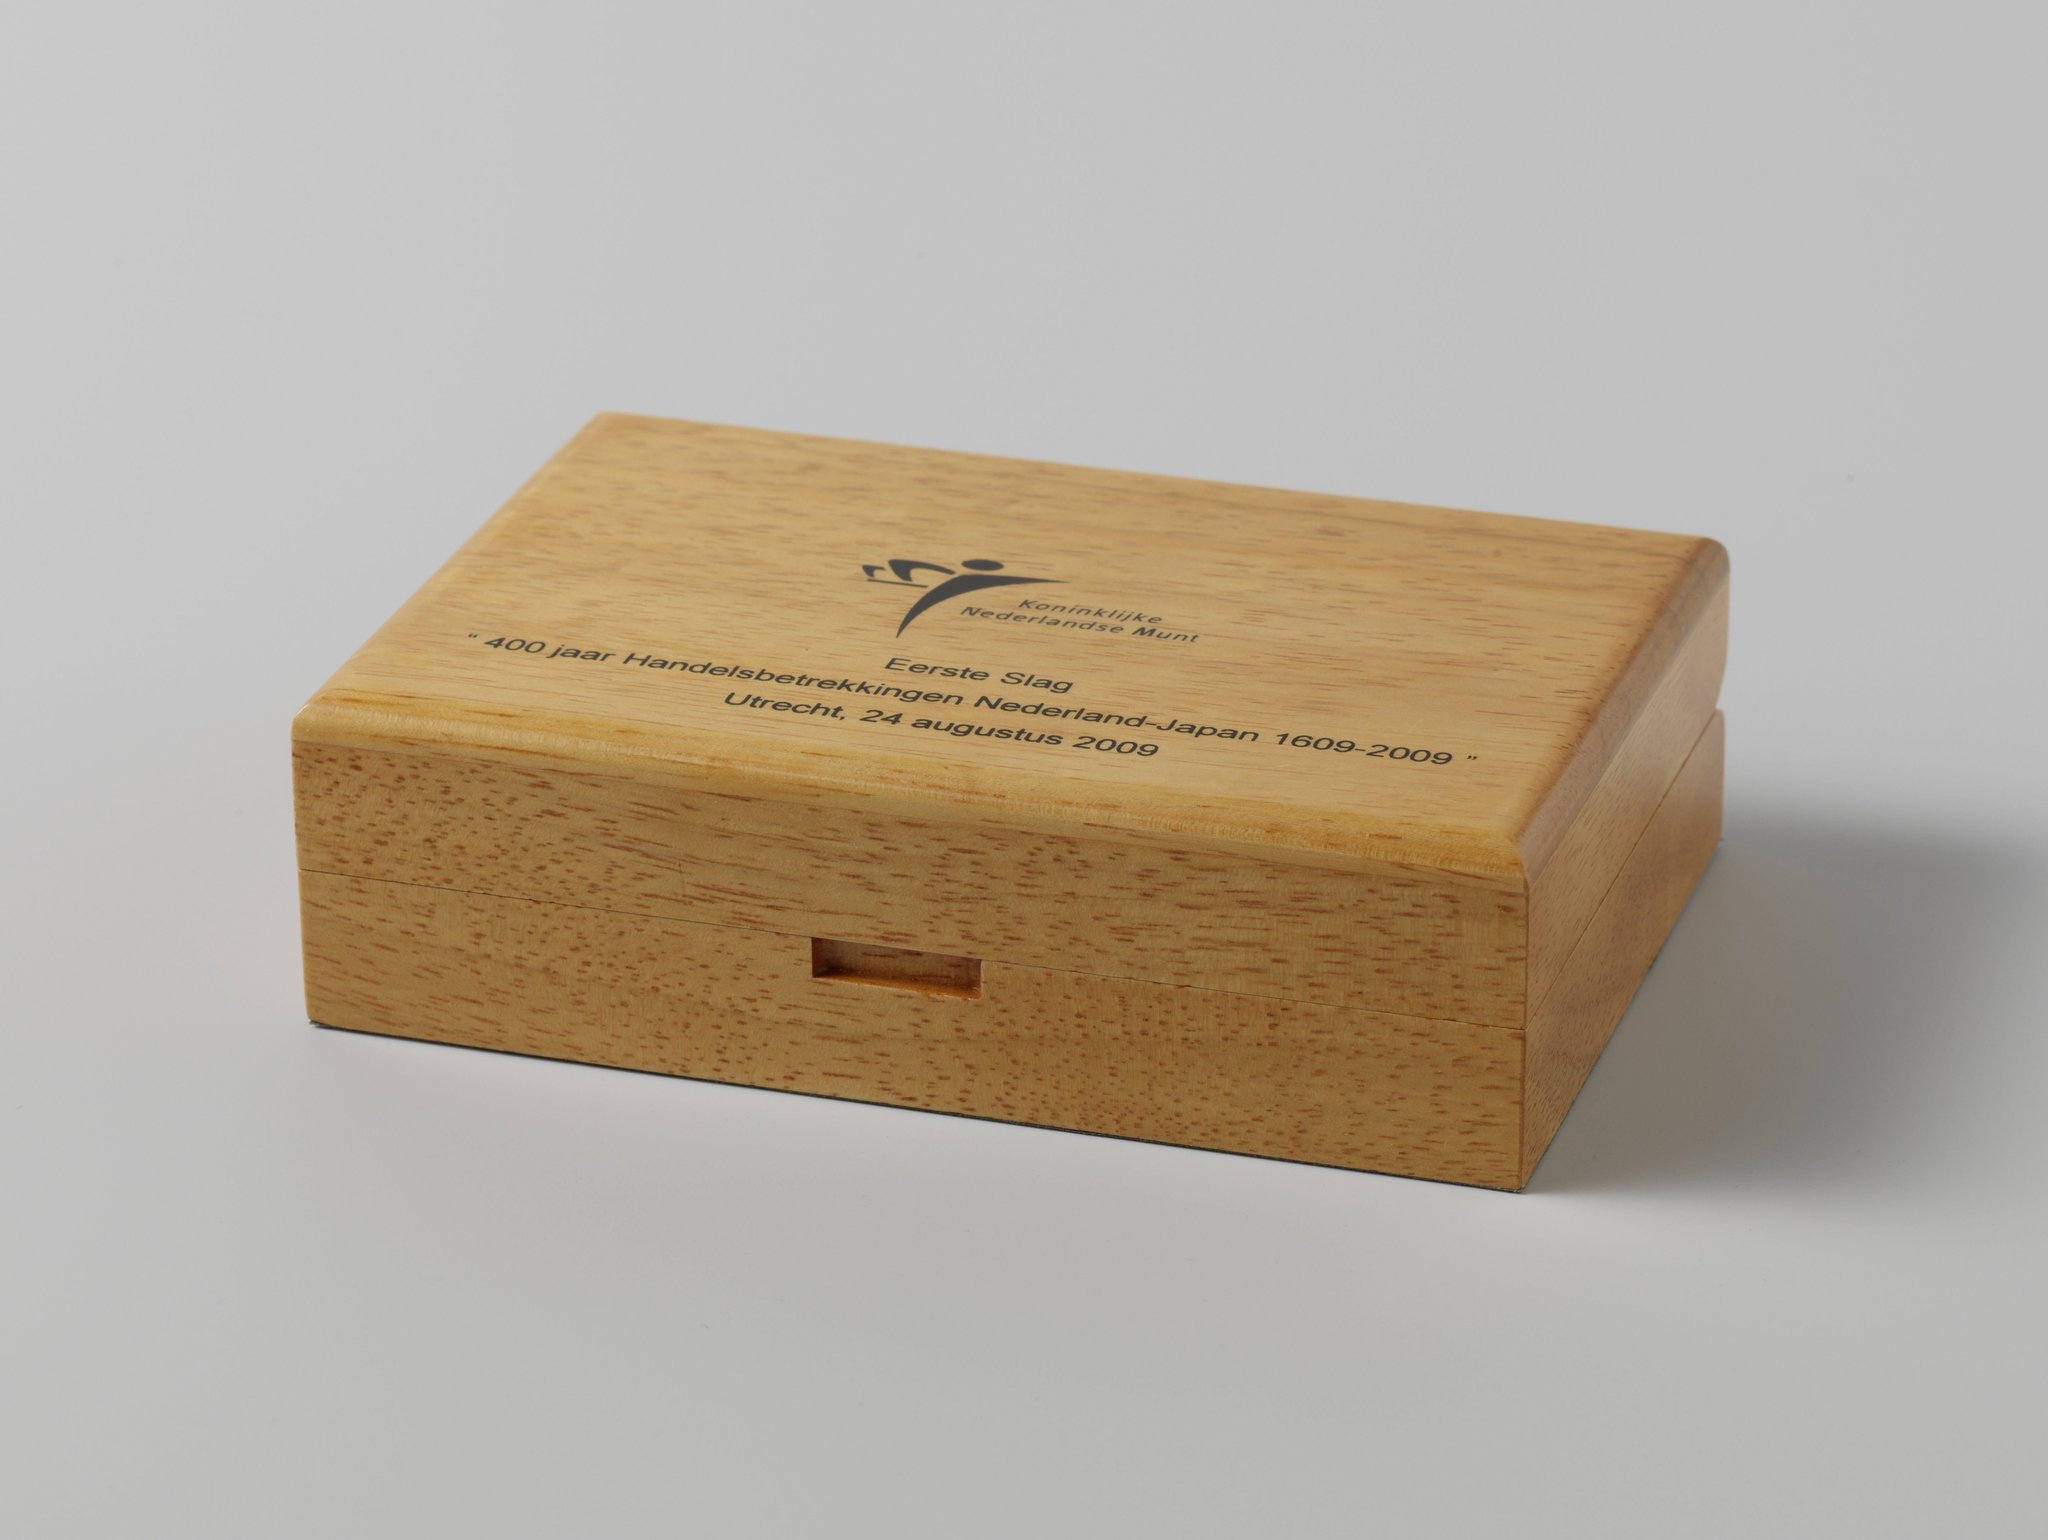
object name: medal box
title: Houten doosje bij munt 400 jaar handelsbetrekkingen Nederland- Japan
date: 2009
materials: paper, velvet, wood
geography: utrecht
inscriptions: inscription: ‘Eerste Slag '400 jaar Handelsbetrekkingen Nederland-Japan 1609-2009' Utrecht, 24 augustus 2009’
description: Houten doos met opschrift, aan binnenzijde bekleed met fluweel waarin een tekstboekje is gestoken.